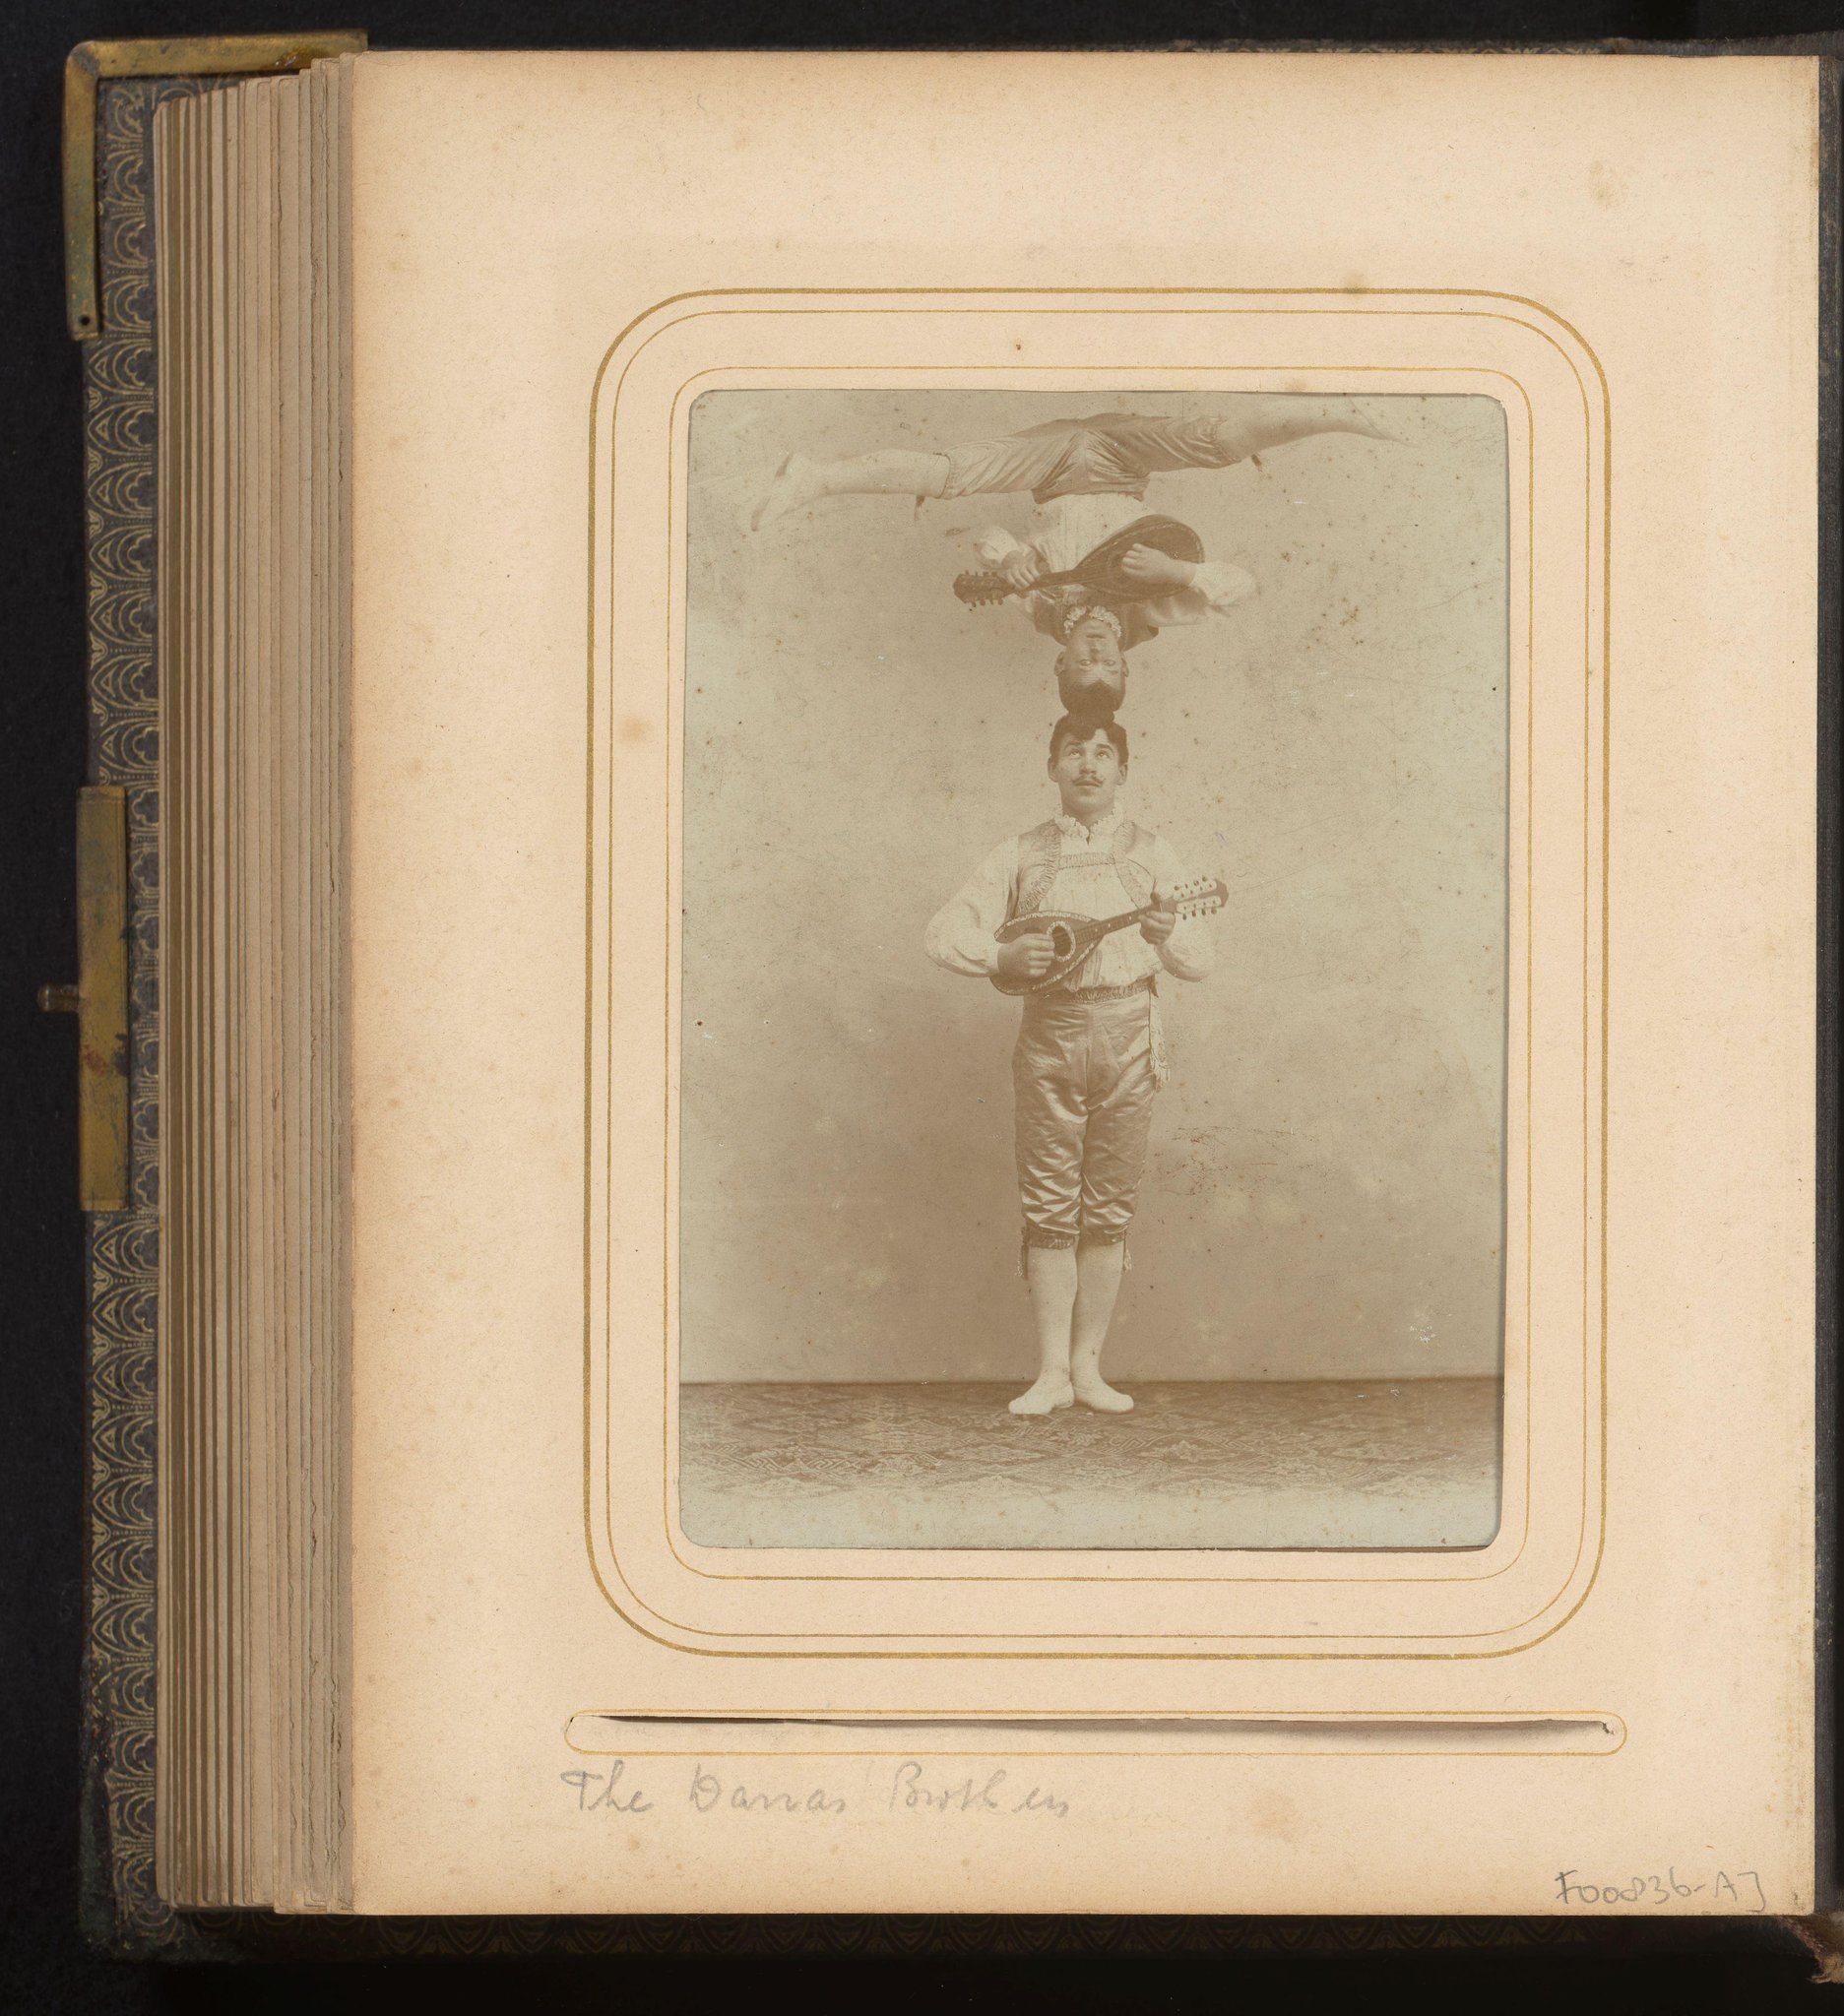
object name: cabinet photograph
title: Portret van de Darras Brothers, acrobaten tijdens truc mandolinespelend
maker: wilhelm scharmann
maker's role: fotograaf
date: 1870-1900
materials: cardboard, photographic support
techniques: collodion silver print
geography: berlin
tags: acrobat ~ circus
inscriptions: collector's mark: ‘Internationale/ Theater-Agentur/ für concert, Circus u. Varieté von S.z. Aschenfarb/ Hamburg/ St. Pauli, Silbersackstr. 16,i’, annotation: ‘The Darras Brothers’, annotation: ‘The Darras Brothers/ Phenomenale hand u. kopf [...]/ gage 15 tage [...]/ 150 gulden’, inscription: ‘Berlin, S.W./ Kommandantenstr. 15/ gegenüber der Beuth-Strasse (...)’